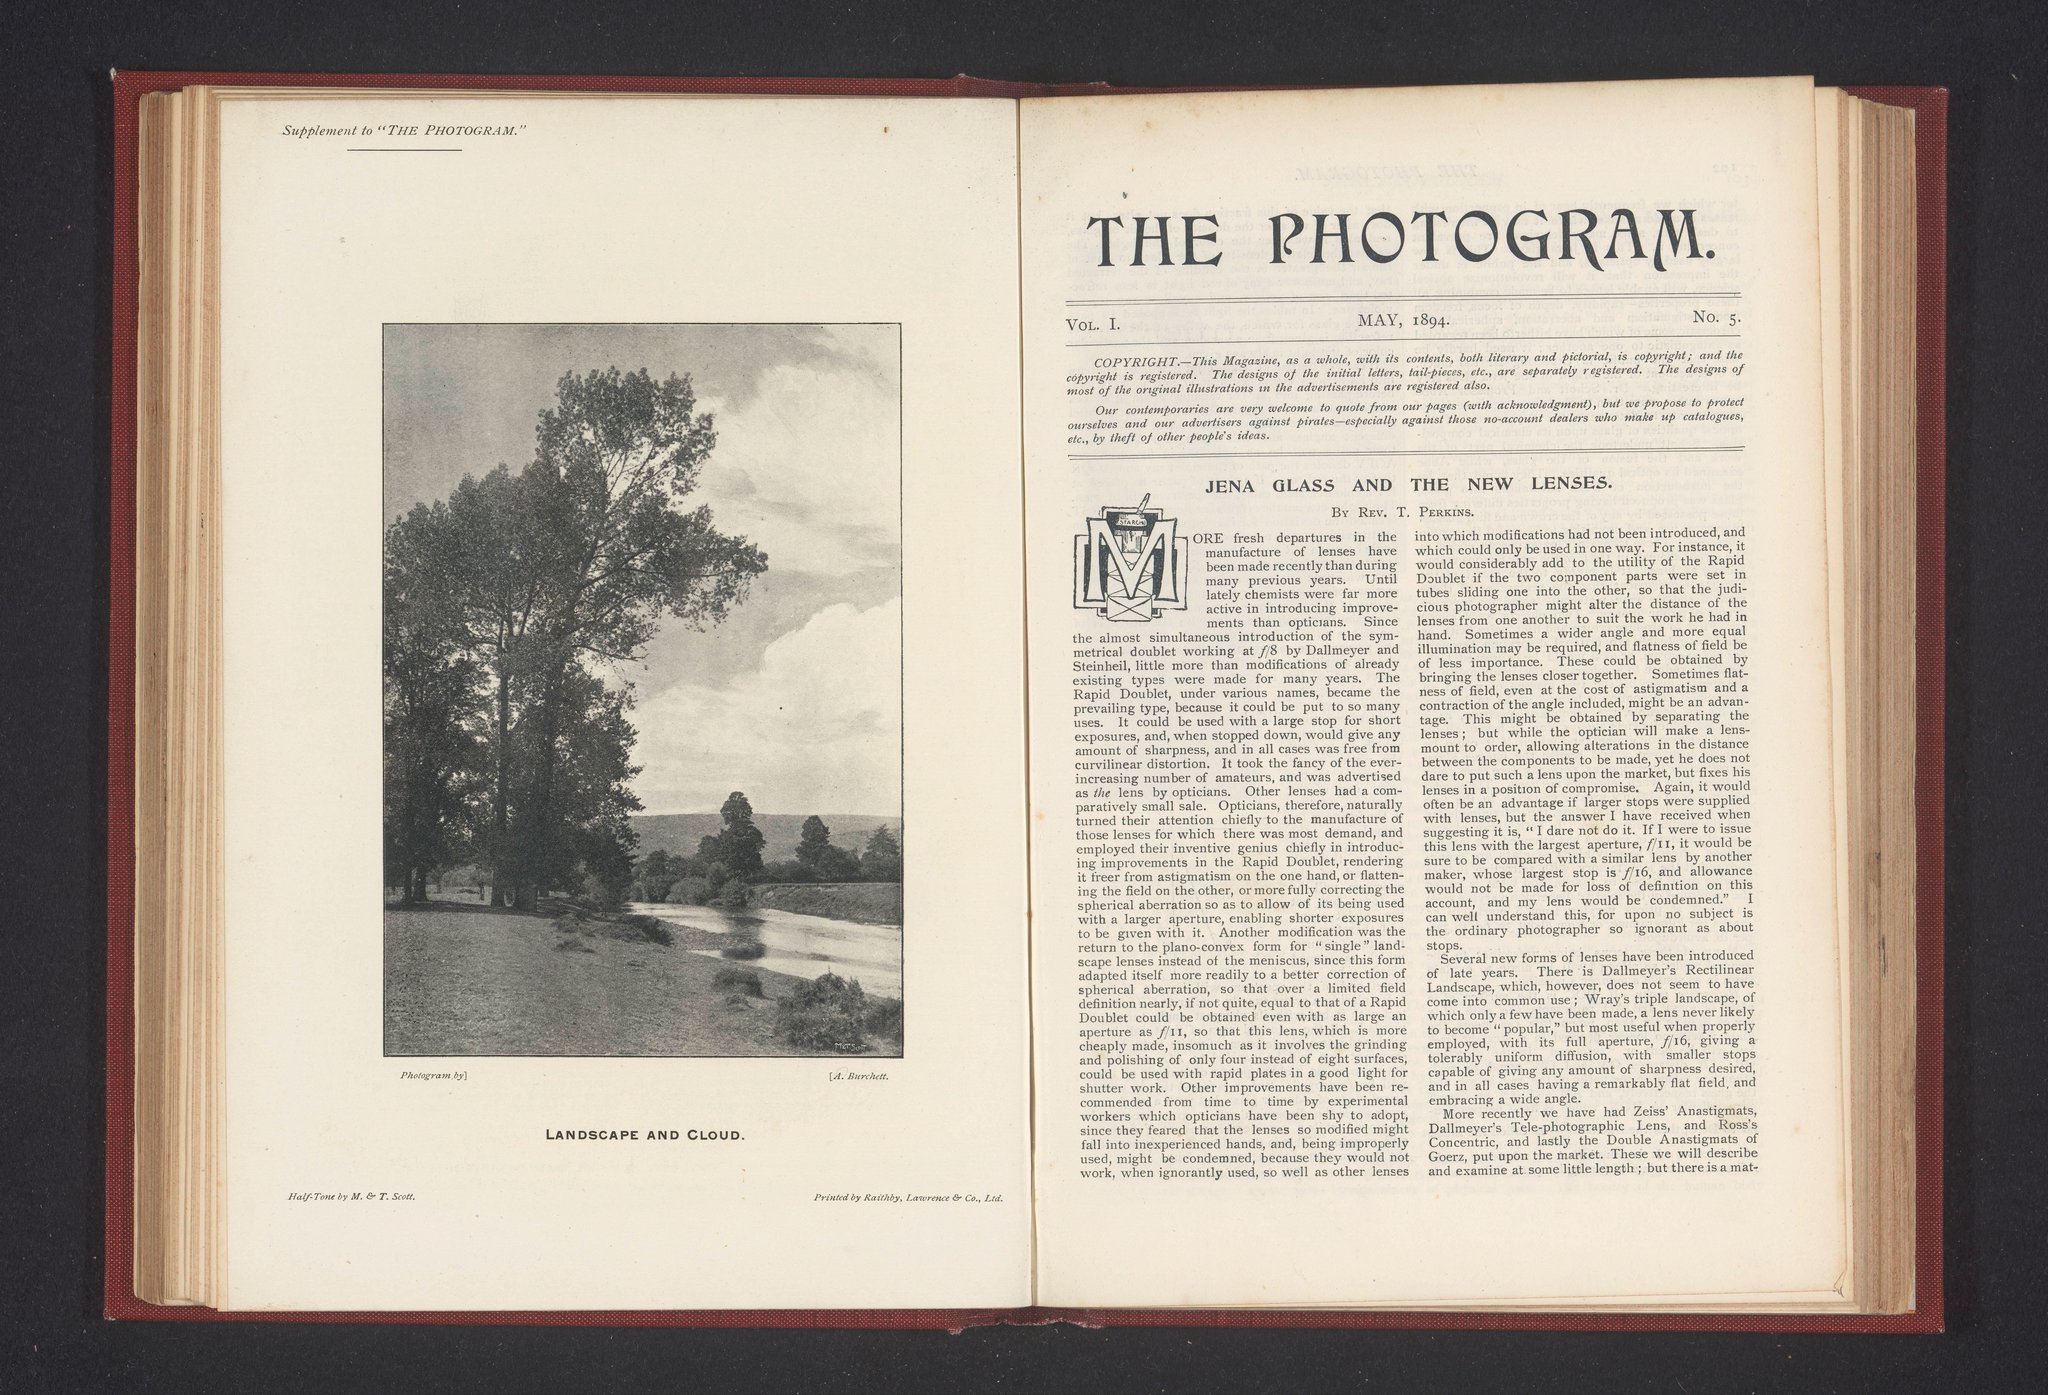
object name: page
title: Landschap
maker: arthur burchett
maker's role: painter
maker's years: 1853-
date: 1889-1894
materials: paper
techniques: autotype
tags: landscapes